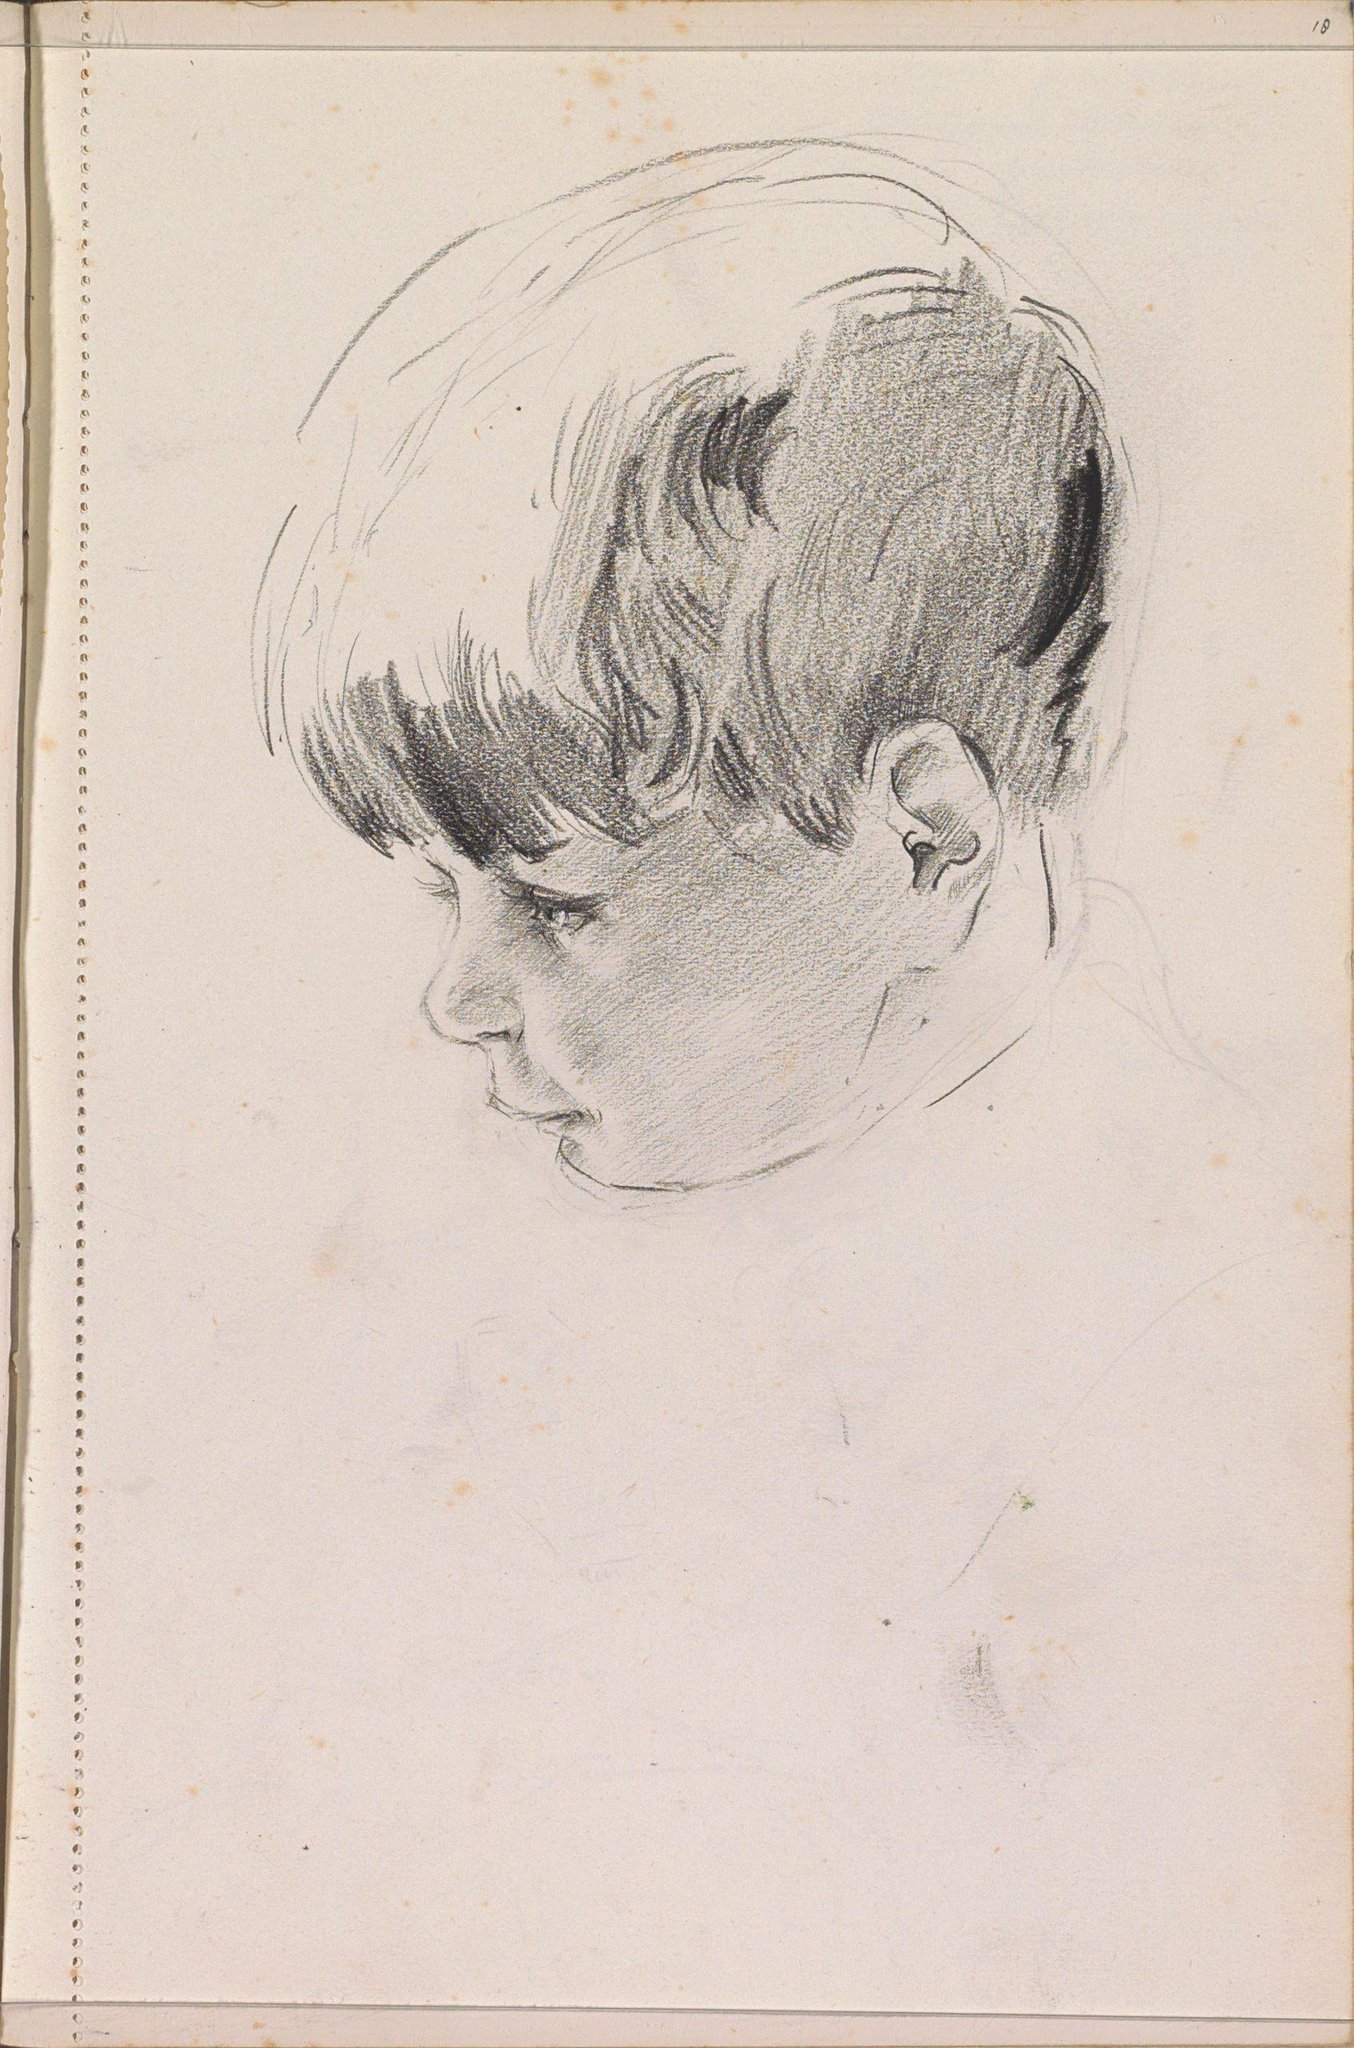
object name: sketchbook leaf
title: Hoofd van een jongen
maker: otto verhagen (i)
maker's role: draughtsman, print maker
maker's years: 1885-1951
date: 1922-1925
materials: chalk, paper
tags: head (human), boy (child between toddler and youth)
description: Pagina 18 uit een schetsboek met 34 bladen.